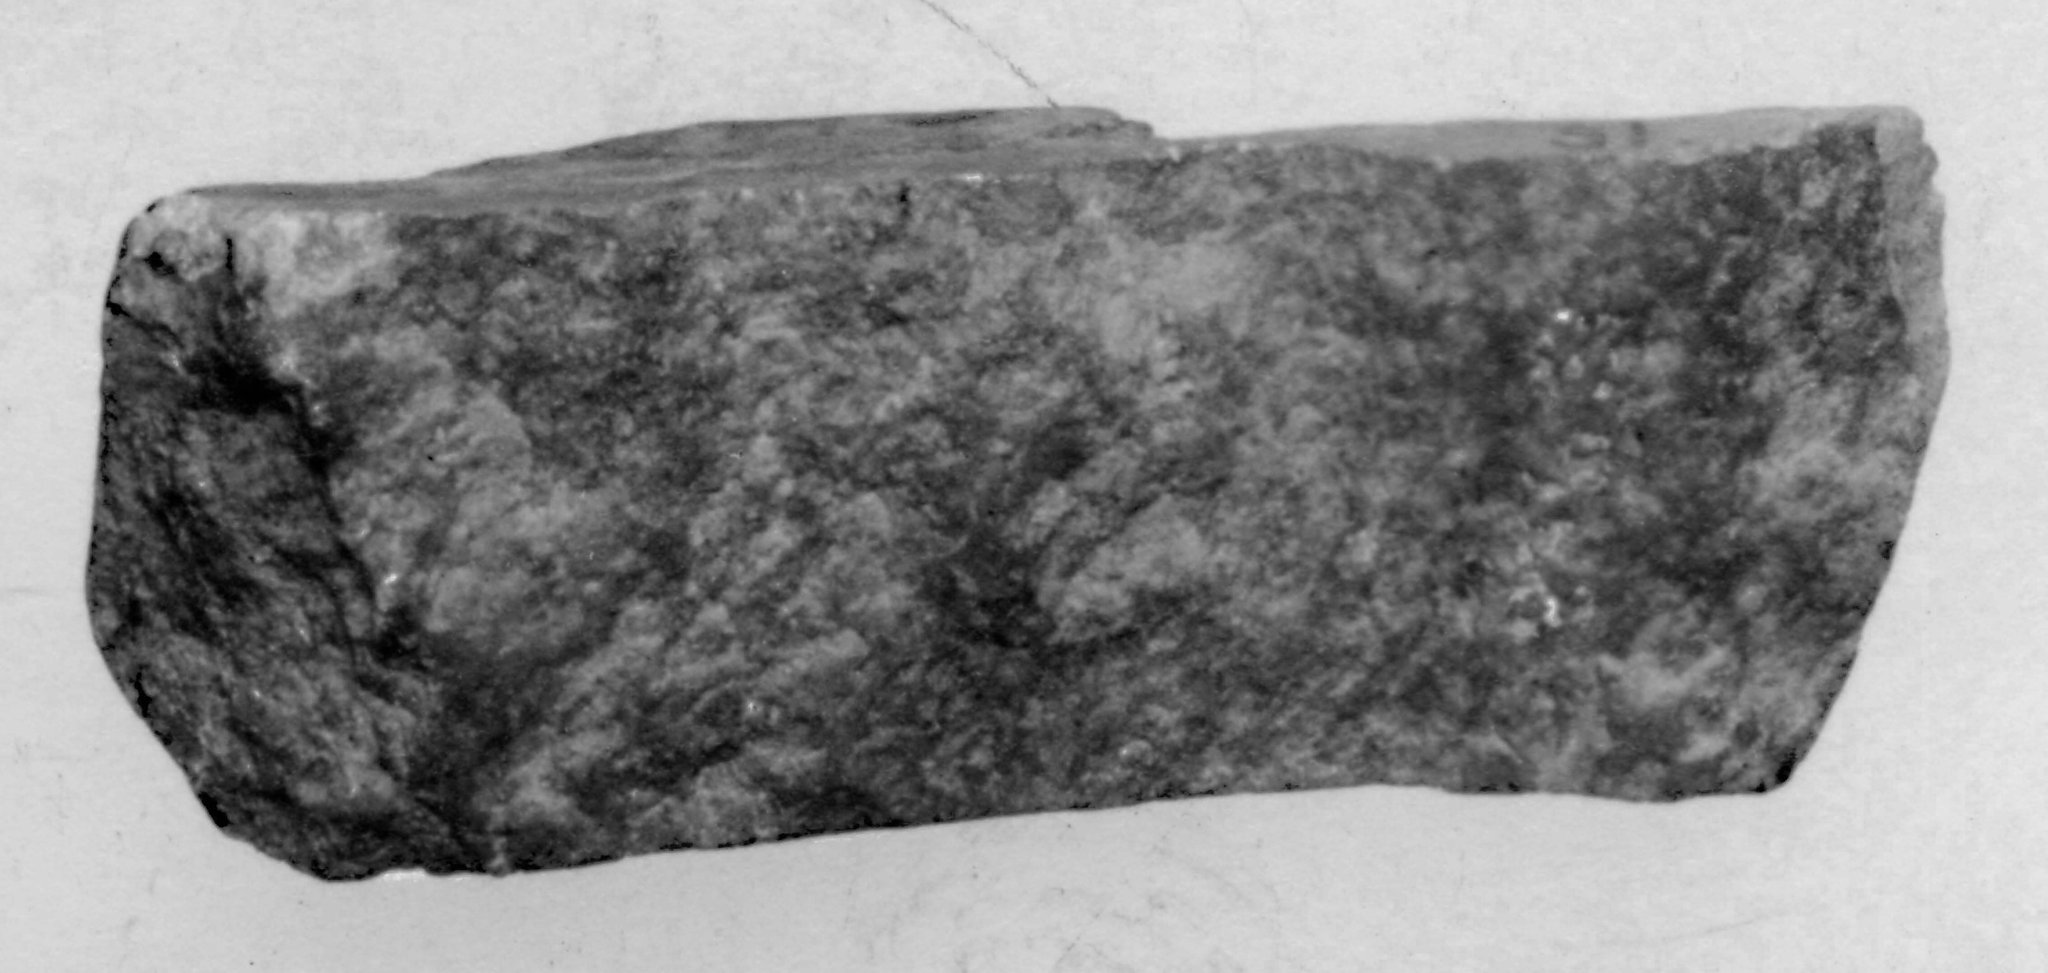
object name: fragment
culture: chinese or turkestani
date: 1902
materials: jade